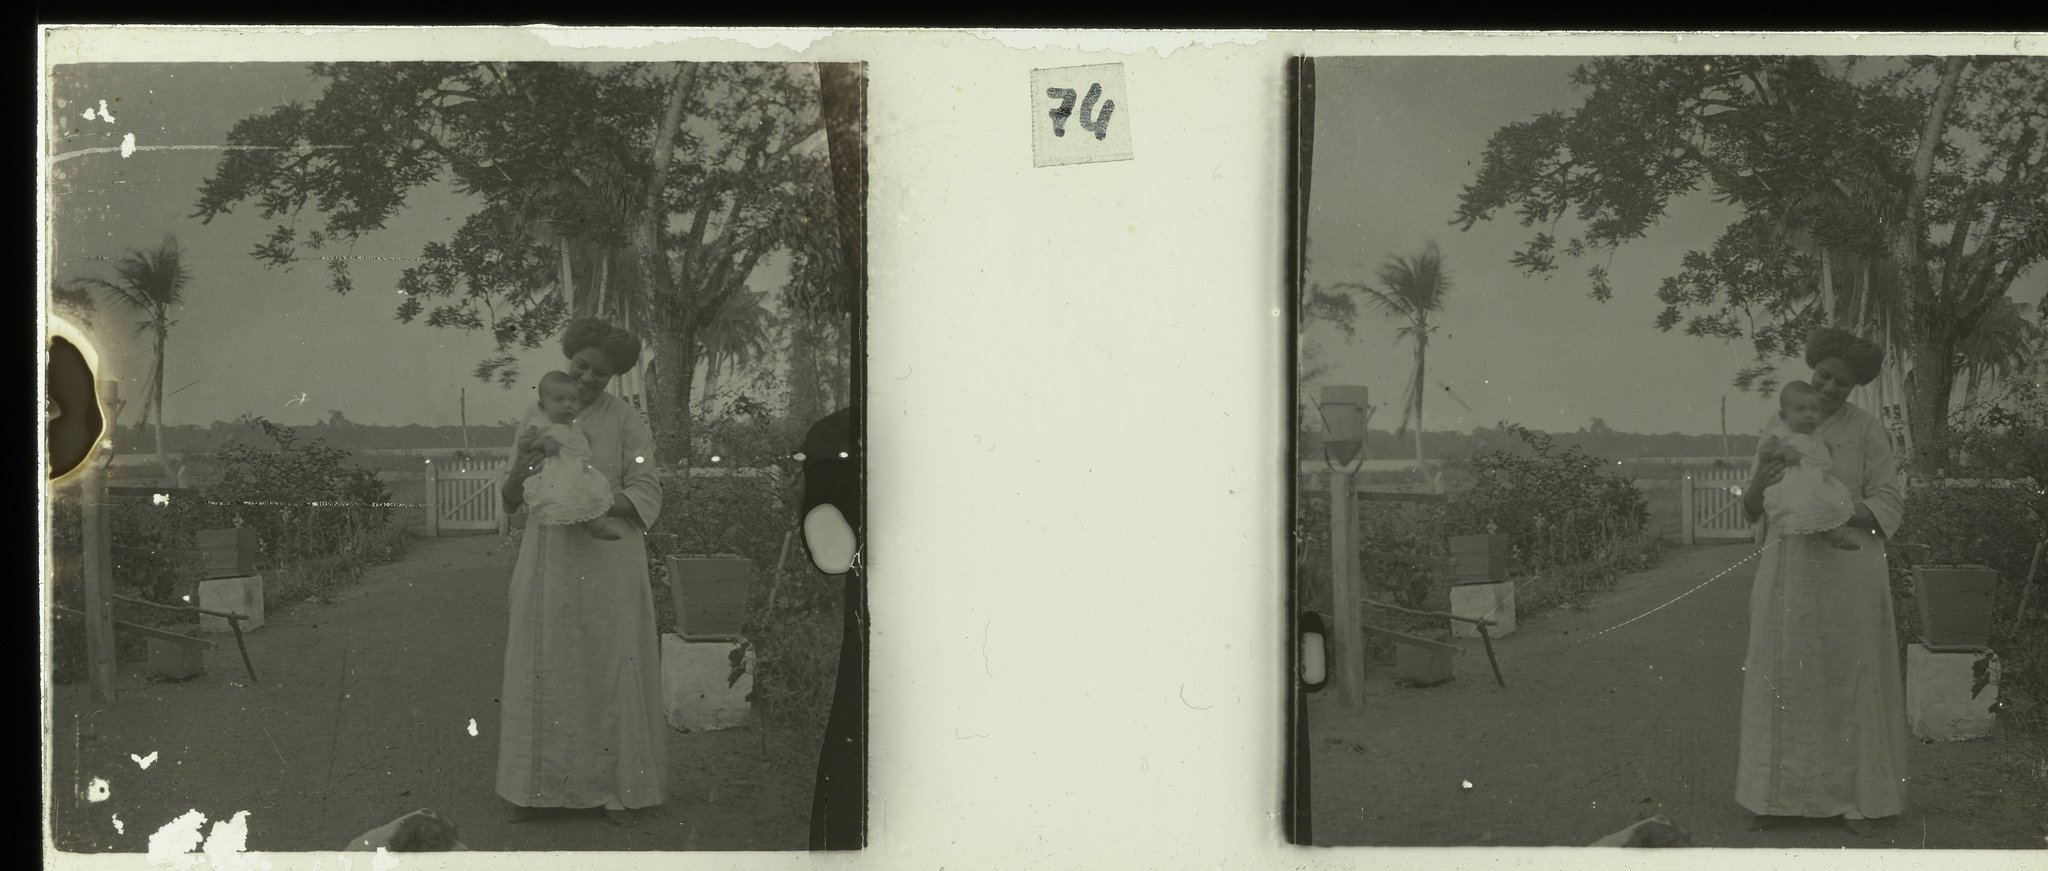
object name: stereograph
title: Lize Brouwers met zoon Gerard op Plantage Accaribo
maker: theodoor brouwers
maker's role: amateurfotograaf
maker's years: 1874-1932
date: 1913-1914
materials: glass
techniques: photography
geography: suriname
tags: haarlem, plantation, suriname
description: In de periode 1911-1932 woonde op plantage Accaribo in Suriname de familie Brouwers van wie de foto's afkomstig zijn. Rond 1910 vond Theodoor Brouwers werk op plantage Accaribo. In 1929 werd hij eigenaar van de plantage. Op Accaribo werden in zijn tijd bananen geproduceerd en wat koffie.